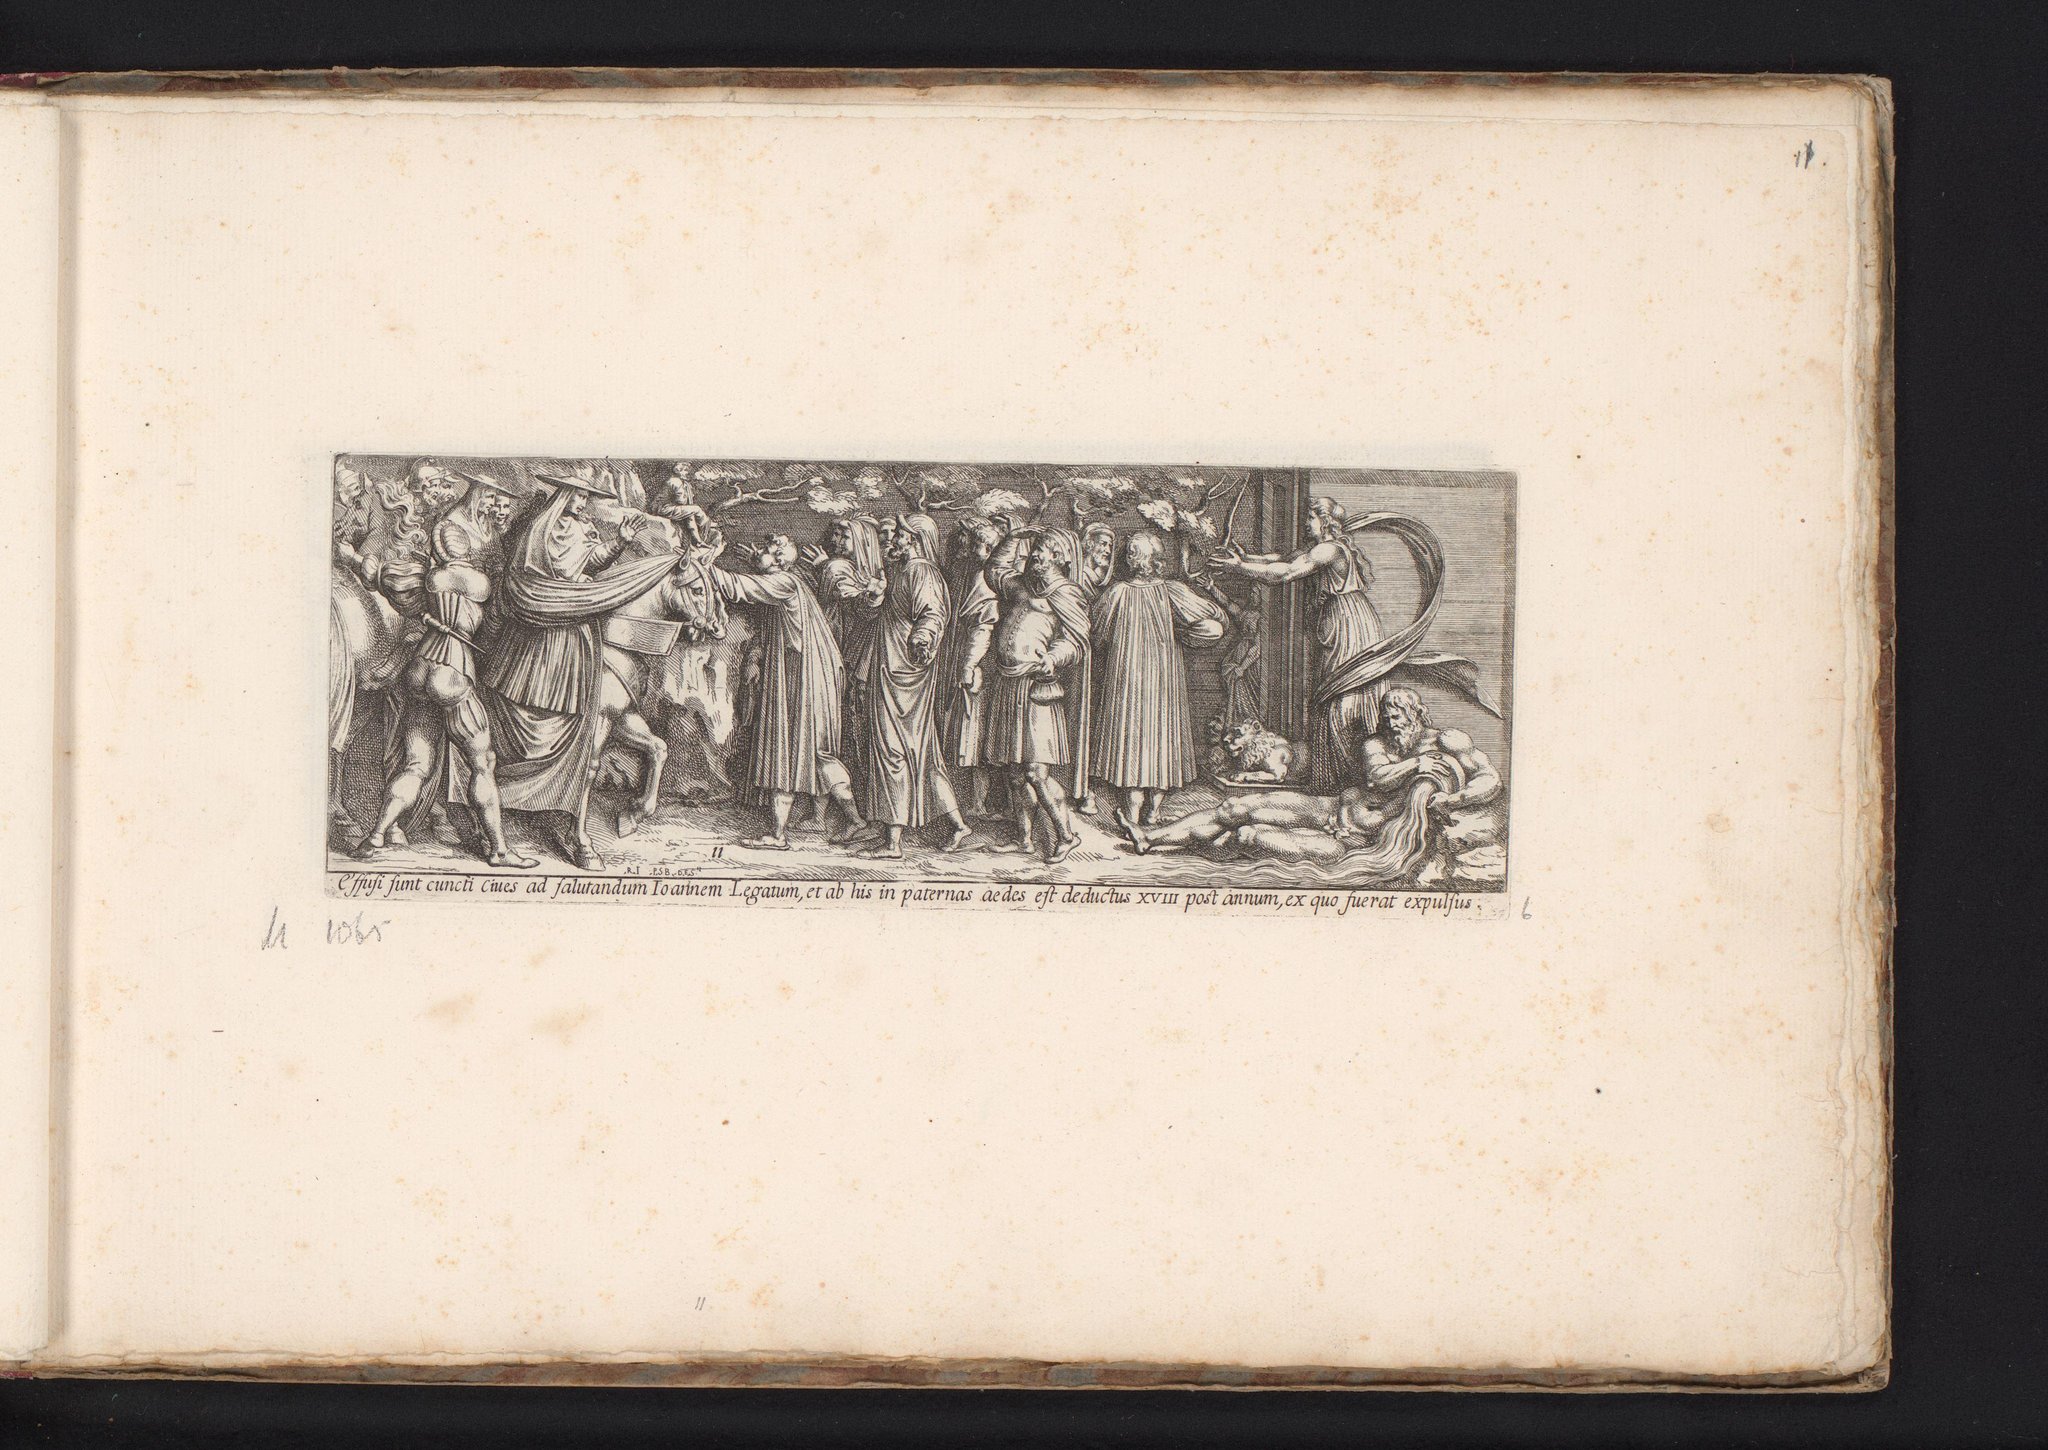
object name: album leaf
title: Scènes uit het leven van paus Leo X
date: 1645-1700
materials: paper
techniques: engraving, etching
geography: italy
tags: rome, leo x, arrival and return ~ travelling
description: Giovanni de' Medici gaat met zijn leger Florence binnen en wordt verwelkomd door een groep Florentijnen. Rechts een liggende riviergod. Titel in ondermarge. Genummerd midden onder: 11. Prent maakt deel uit van een album.